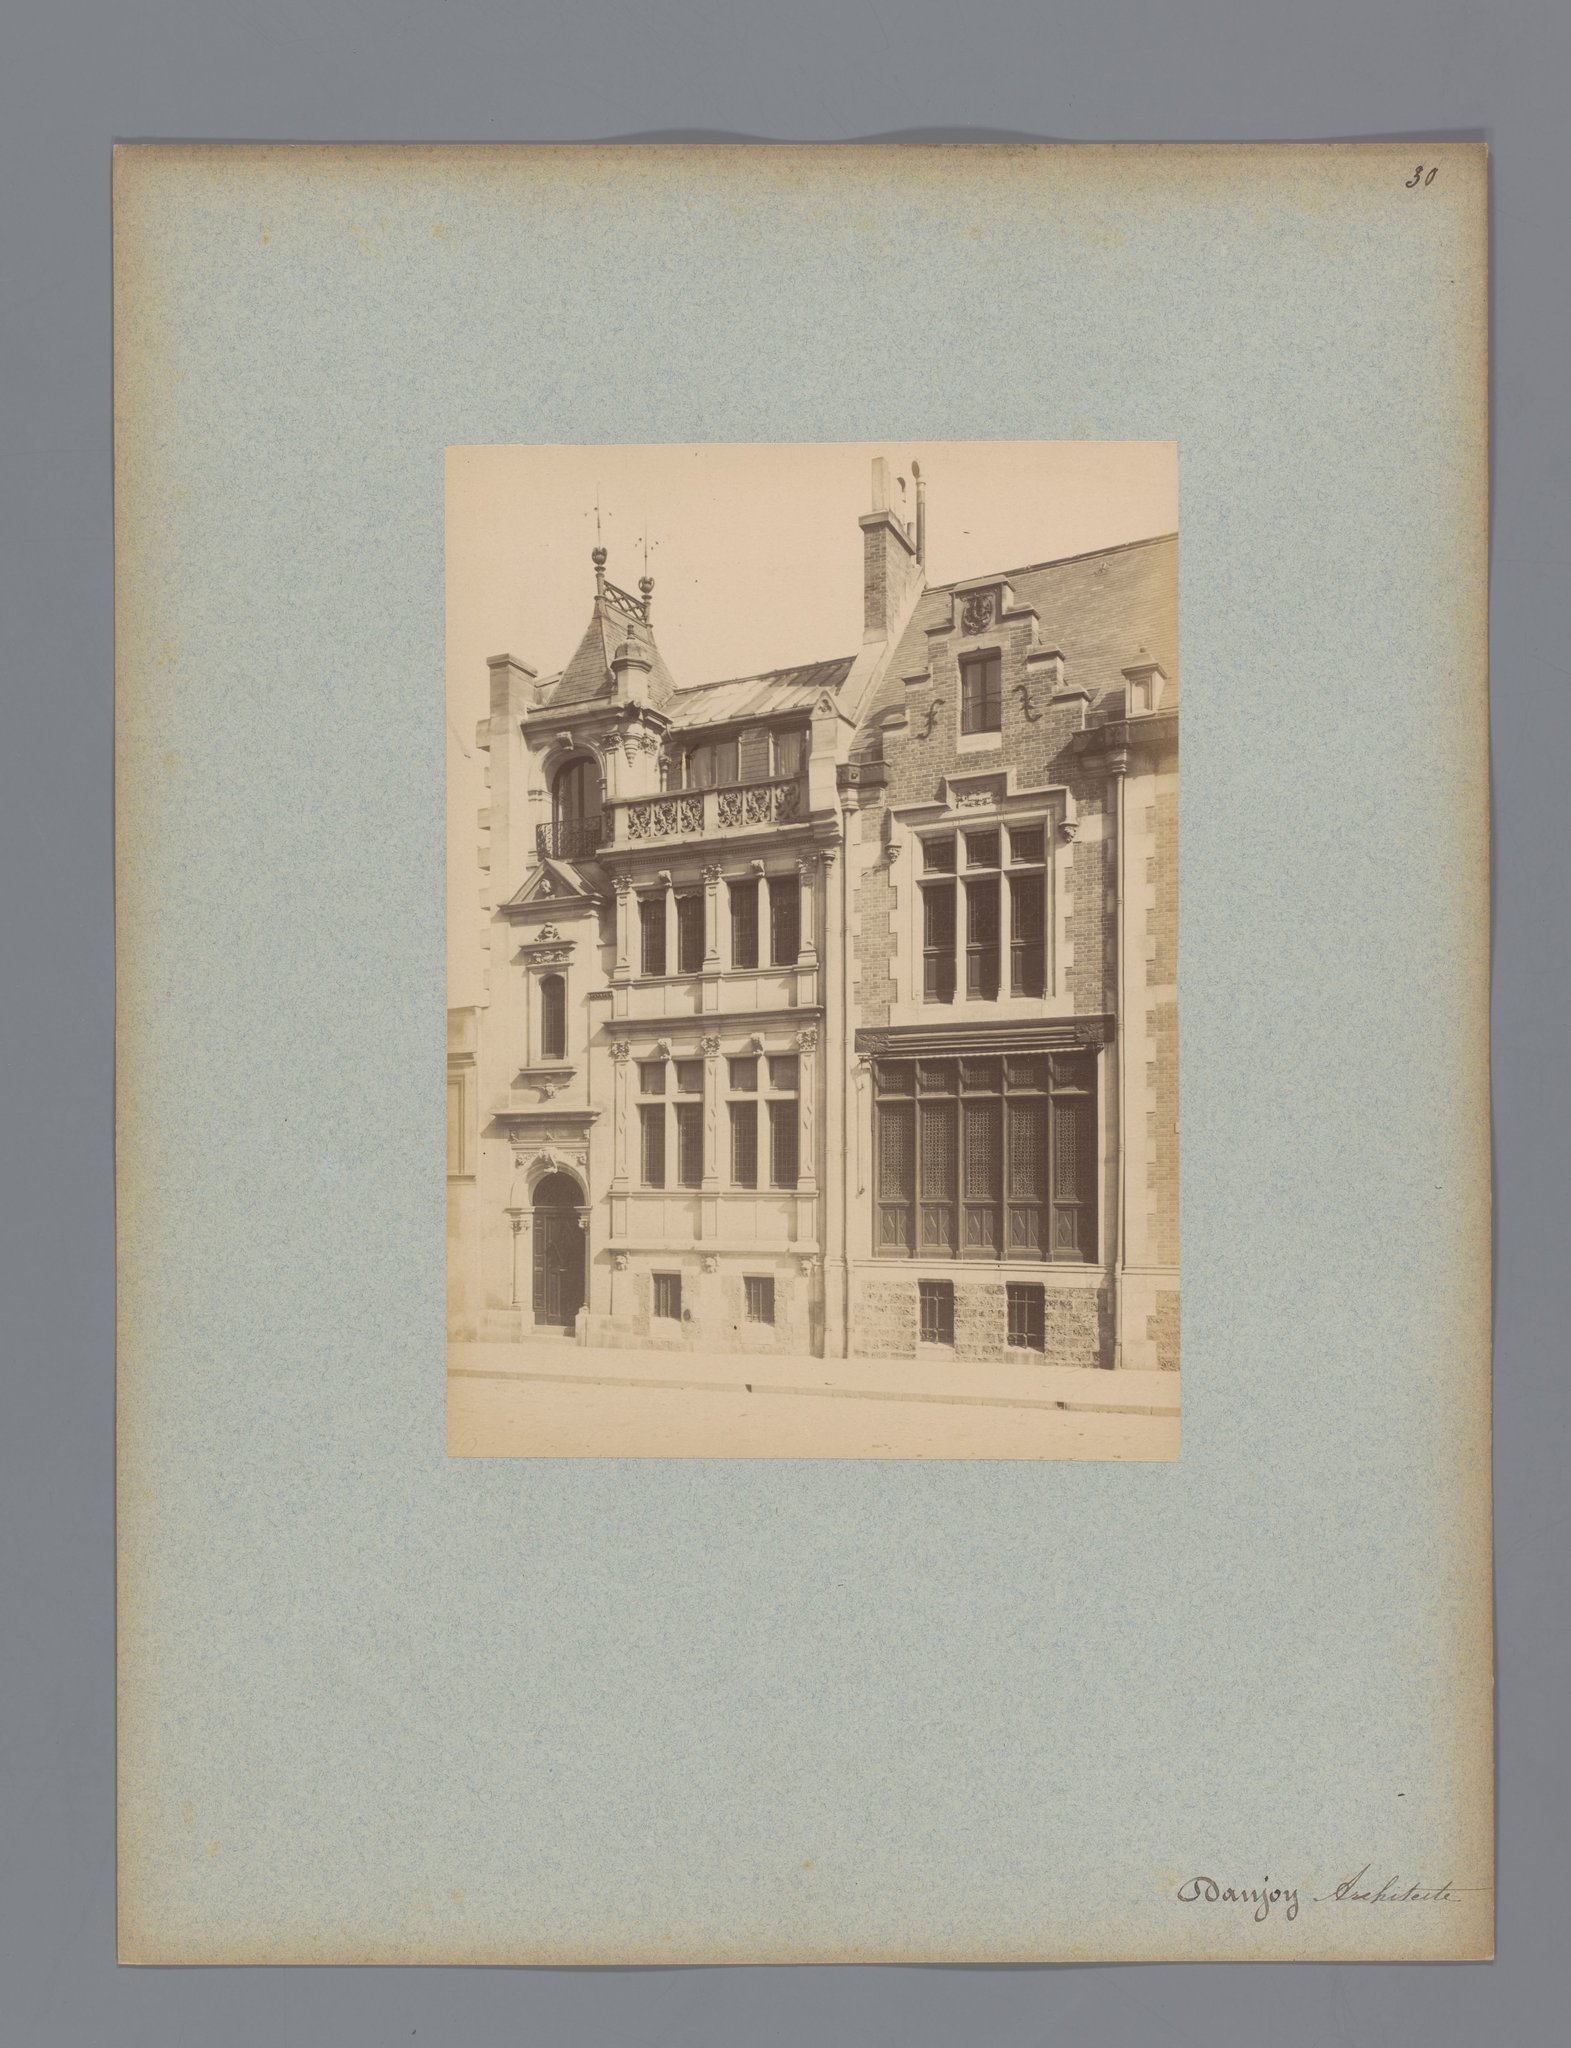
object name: photograph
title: Façade van een gebouw in Parijs, ontworpen door Jean-Charles Danjoy of Edouard Danjoy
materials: photographic support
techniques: albumen print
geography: paris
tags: urban housing, façade (of house or building), paris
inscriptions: number: ‘30’, name: ‘Danjoy Architecte’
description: Deze foto maakt deel uit van een omslag met 35 foto's en een titelblad.